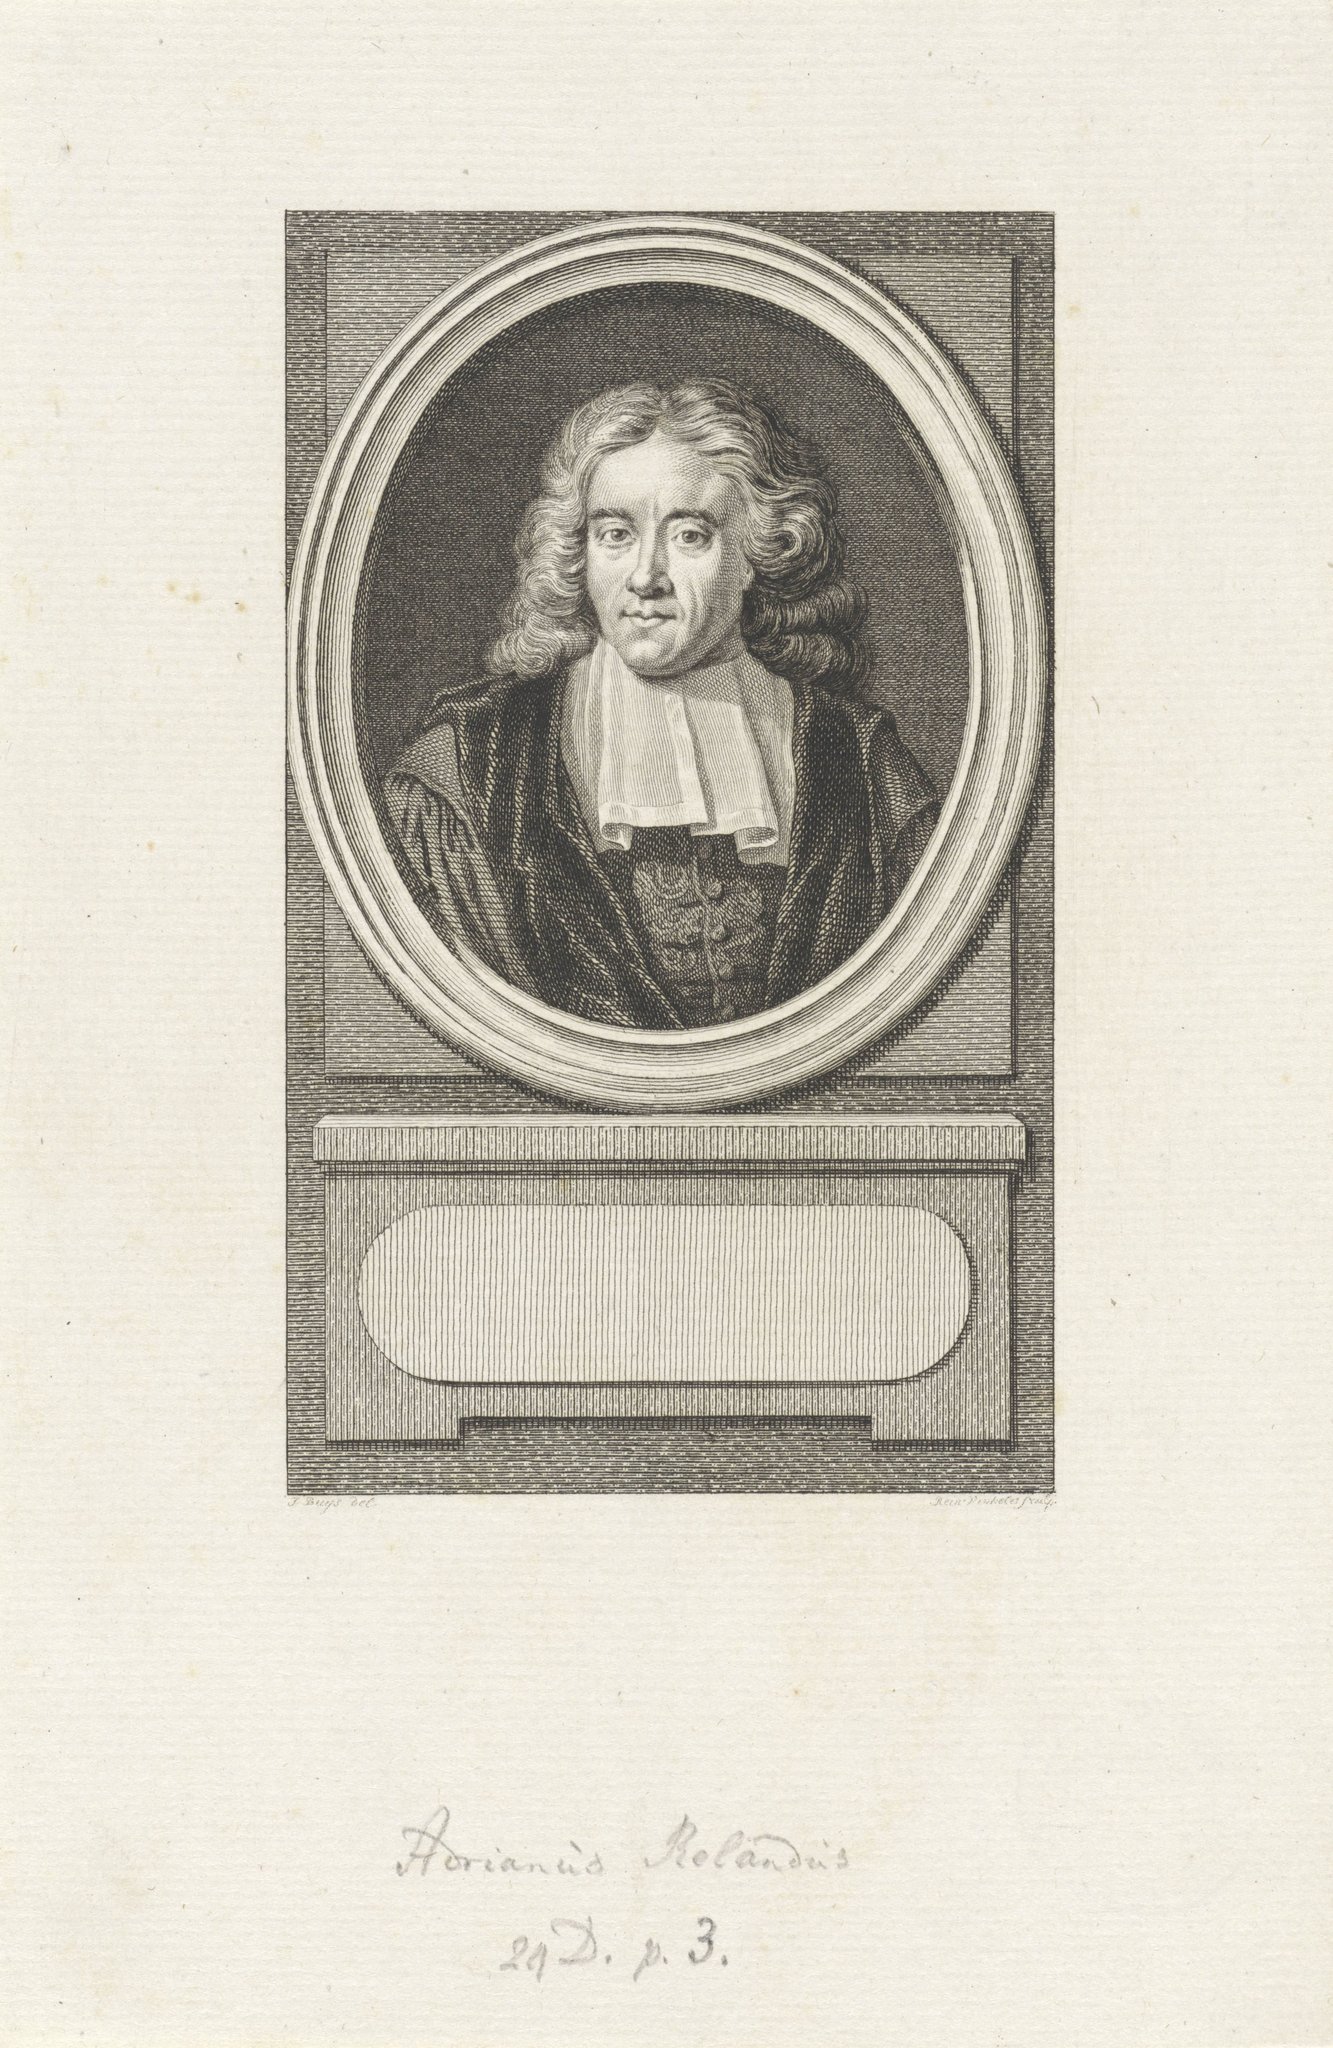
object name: print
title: Portret van Adriaan Reland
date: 1791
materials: paper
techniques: engraving, etching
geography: amsterdam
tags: utrecht, adriaan reeland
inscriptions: collector's mark: Lugt 240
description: Latere staat prent gebruikt als boekillustratie in: Kok, Jacobus. Vaderlandsch woordenboek : met kaarten, plaaten en pourtraitten. Amsterdam: Johannes Allart, 1785-1796. Deel XXIV.